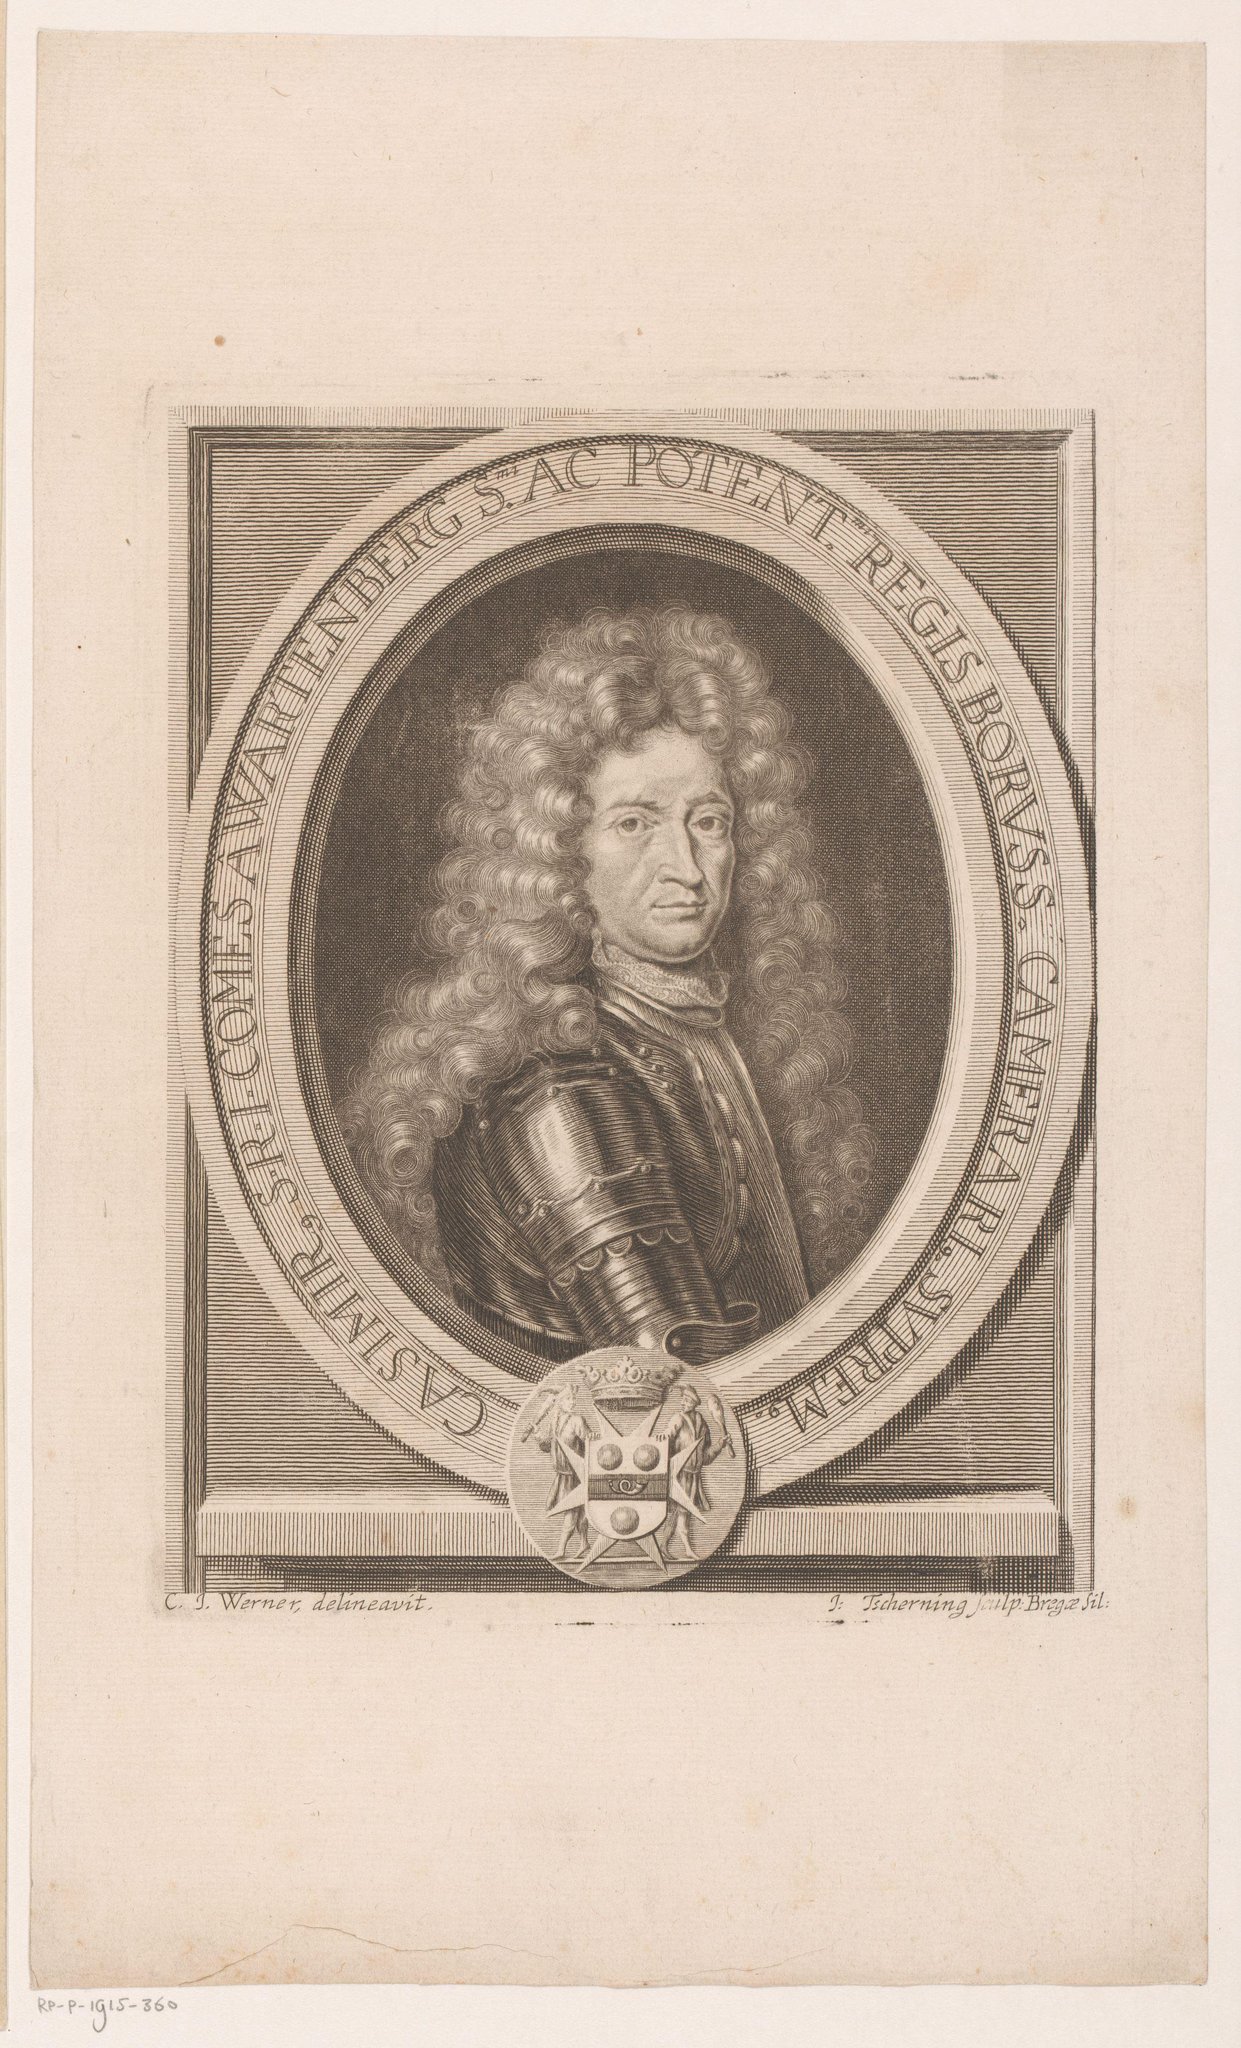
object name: print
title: Portret van Johann Casimir Kolbe van Wartenberg II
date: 1694-1729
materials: paper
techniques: engraving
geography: breslau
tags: armour, historical persons, armorial bearing, heraldry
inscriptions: collector's mark: Lugt 2228